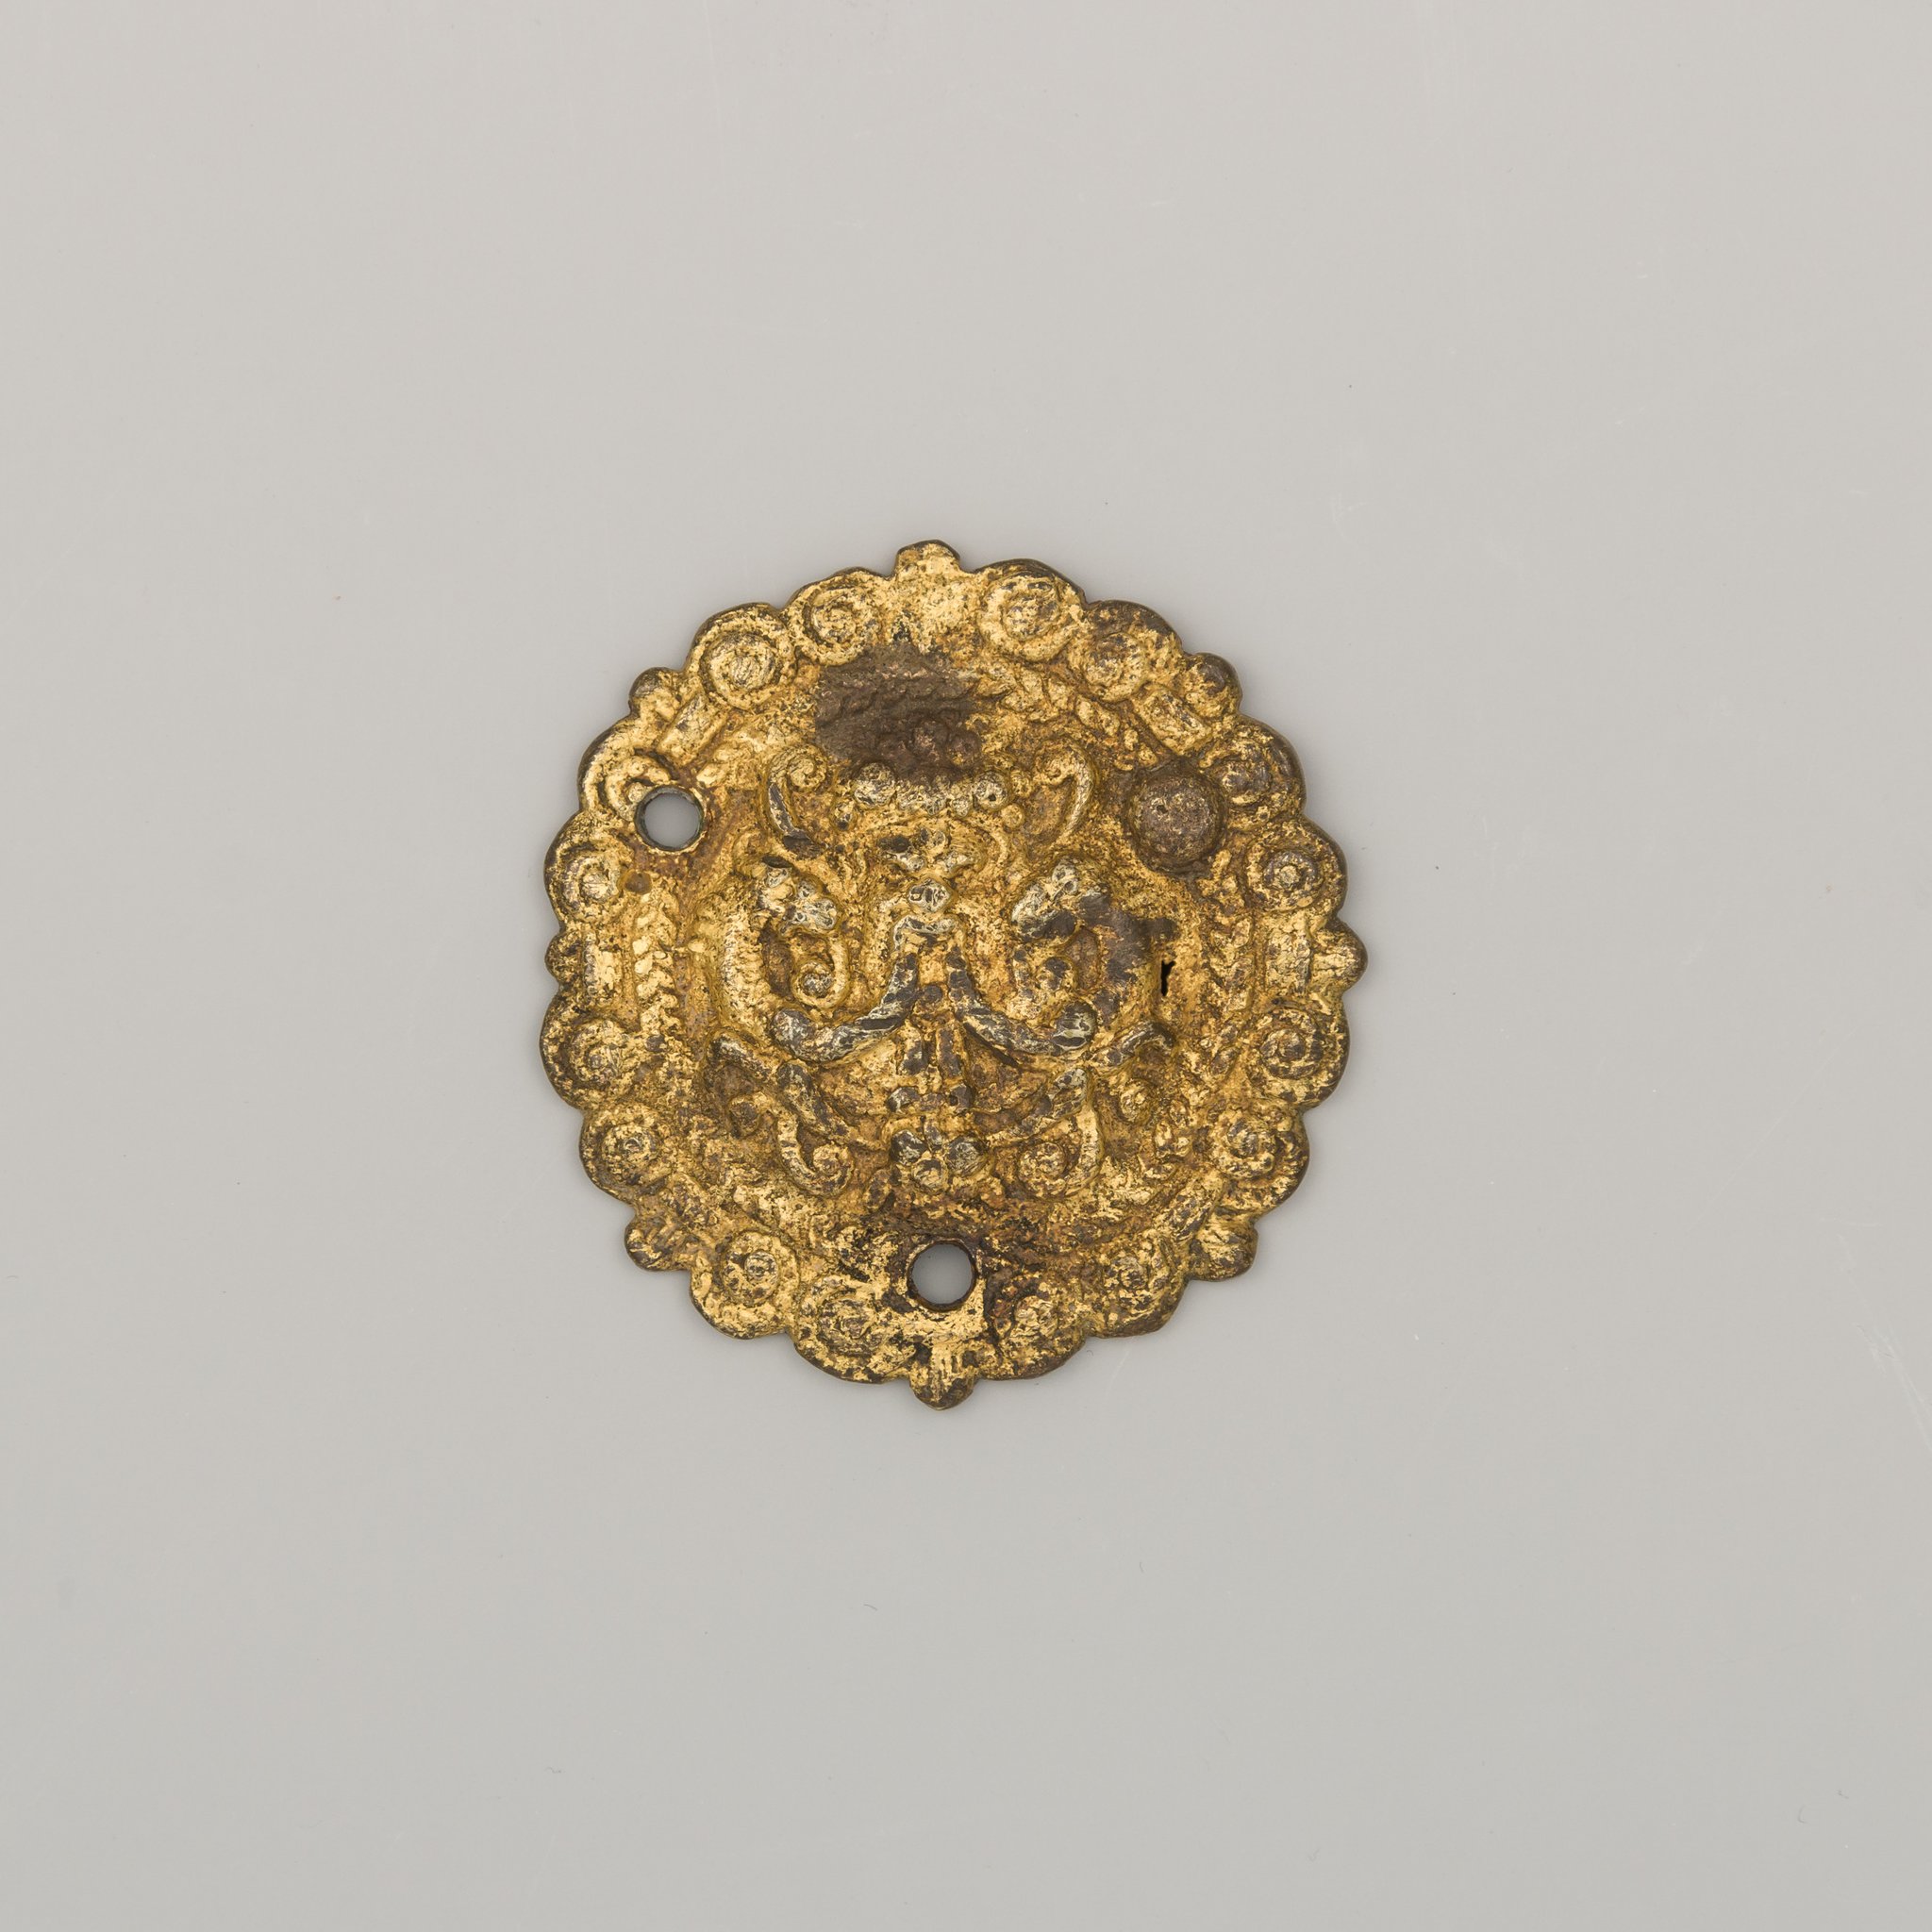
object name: bit bos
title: Bit Boss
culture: german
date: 1567-1700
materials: copper alloy, gold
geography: germany